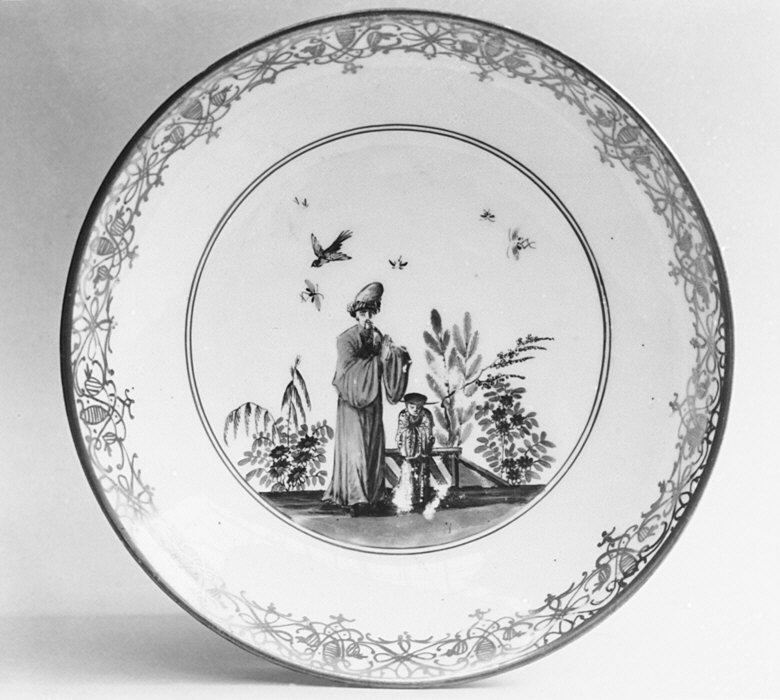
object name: saucer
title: Saucer (part of a set)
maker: meissen manufactory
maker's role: manufactory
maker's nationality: german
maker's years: 1710-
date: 1735-1740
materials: hard paste porcelain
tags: birds,chinoiserie,men